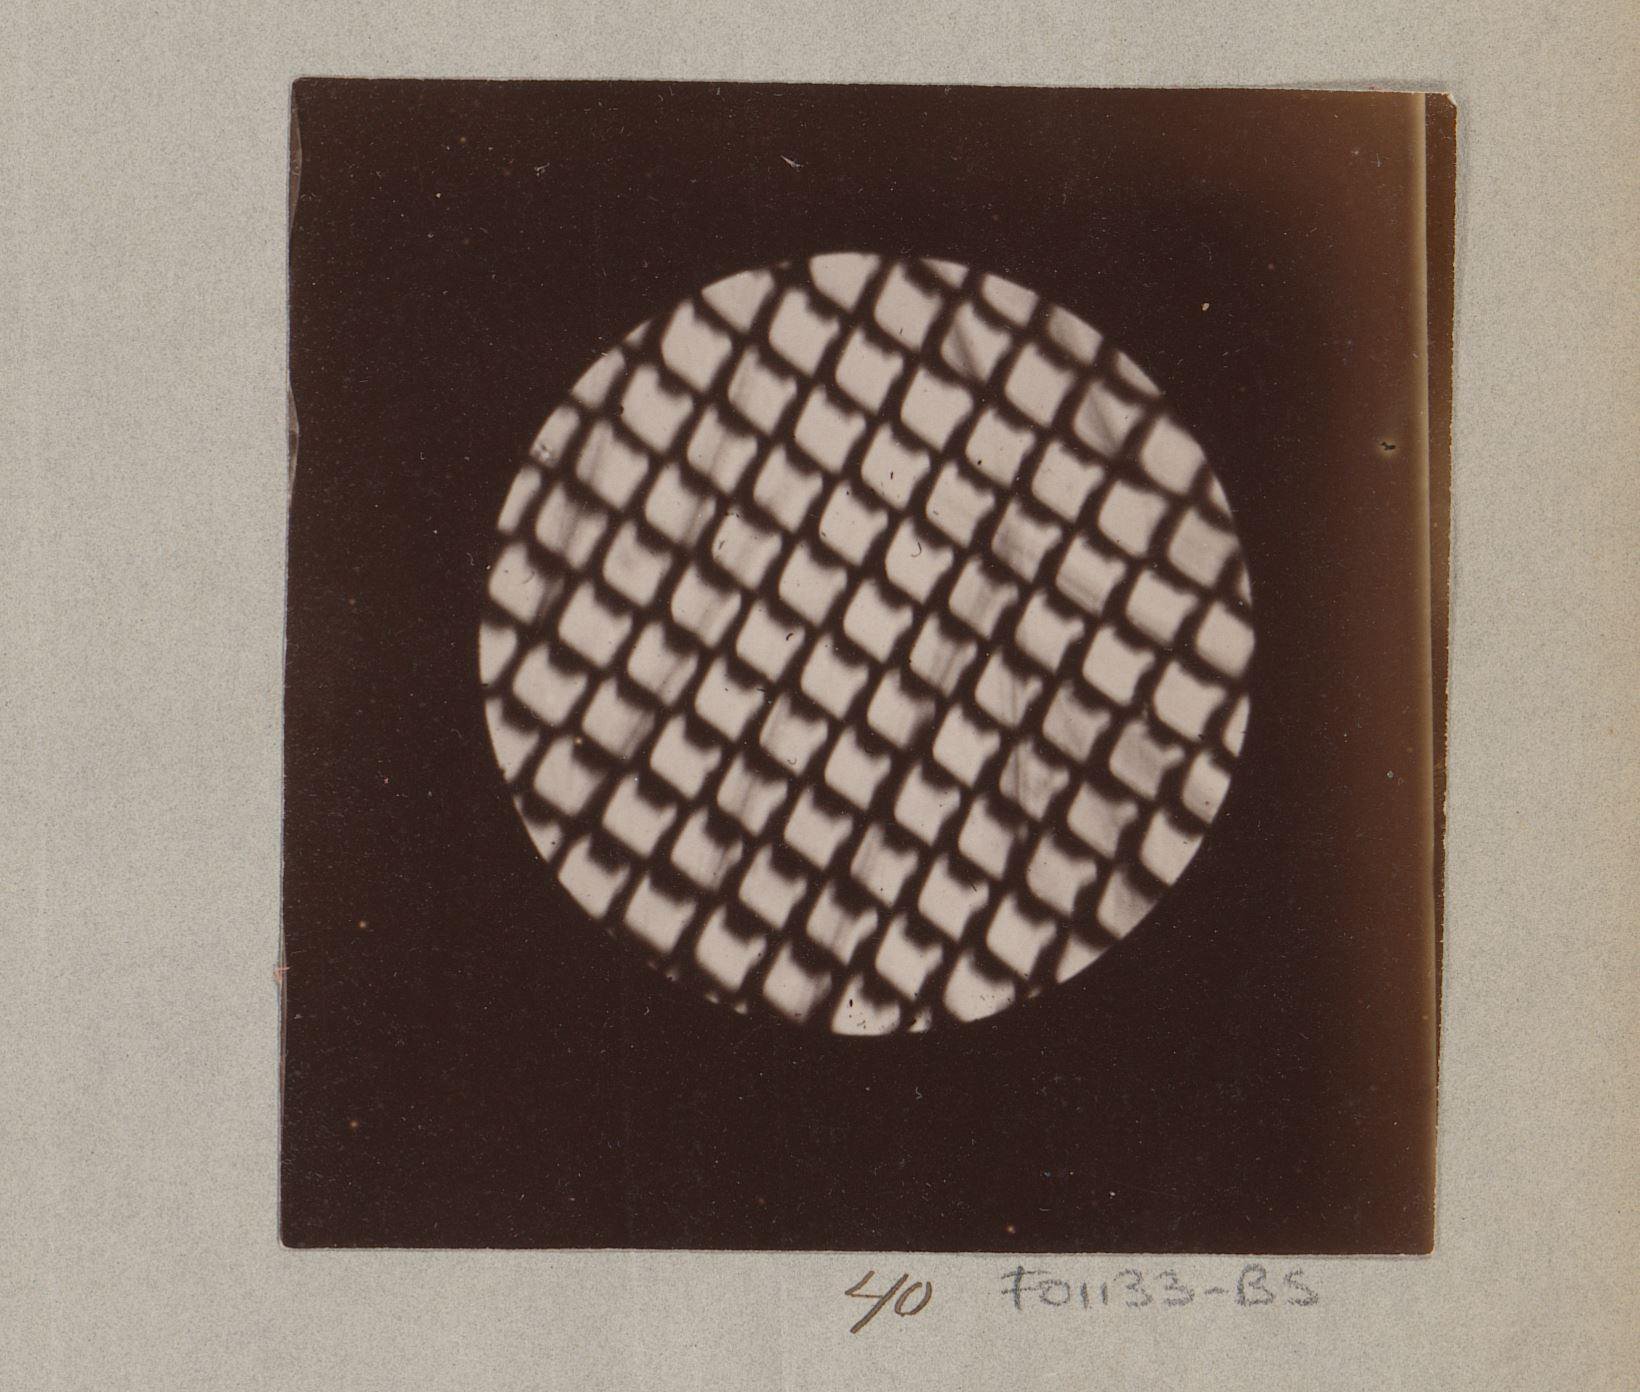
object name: album leaf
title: Microscopische opname van een vliegenoog, 170 keer vergroot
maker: marinus pieter filbri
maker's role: instrument maker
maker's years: 1852-1917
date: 1887-1888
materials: paper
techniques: albumen print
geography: netherlands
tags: insects: fly, netherlands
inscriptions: number: ‘40’, inscription: ‘No. 40. Benaming Oog van een vlieg, 170 x vergroot, pose (?), Bemerking Magnesium licht’